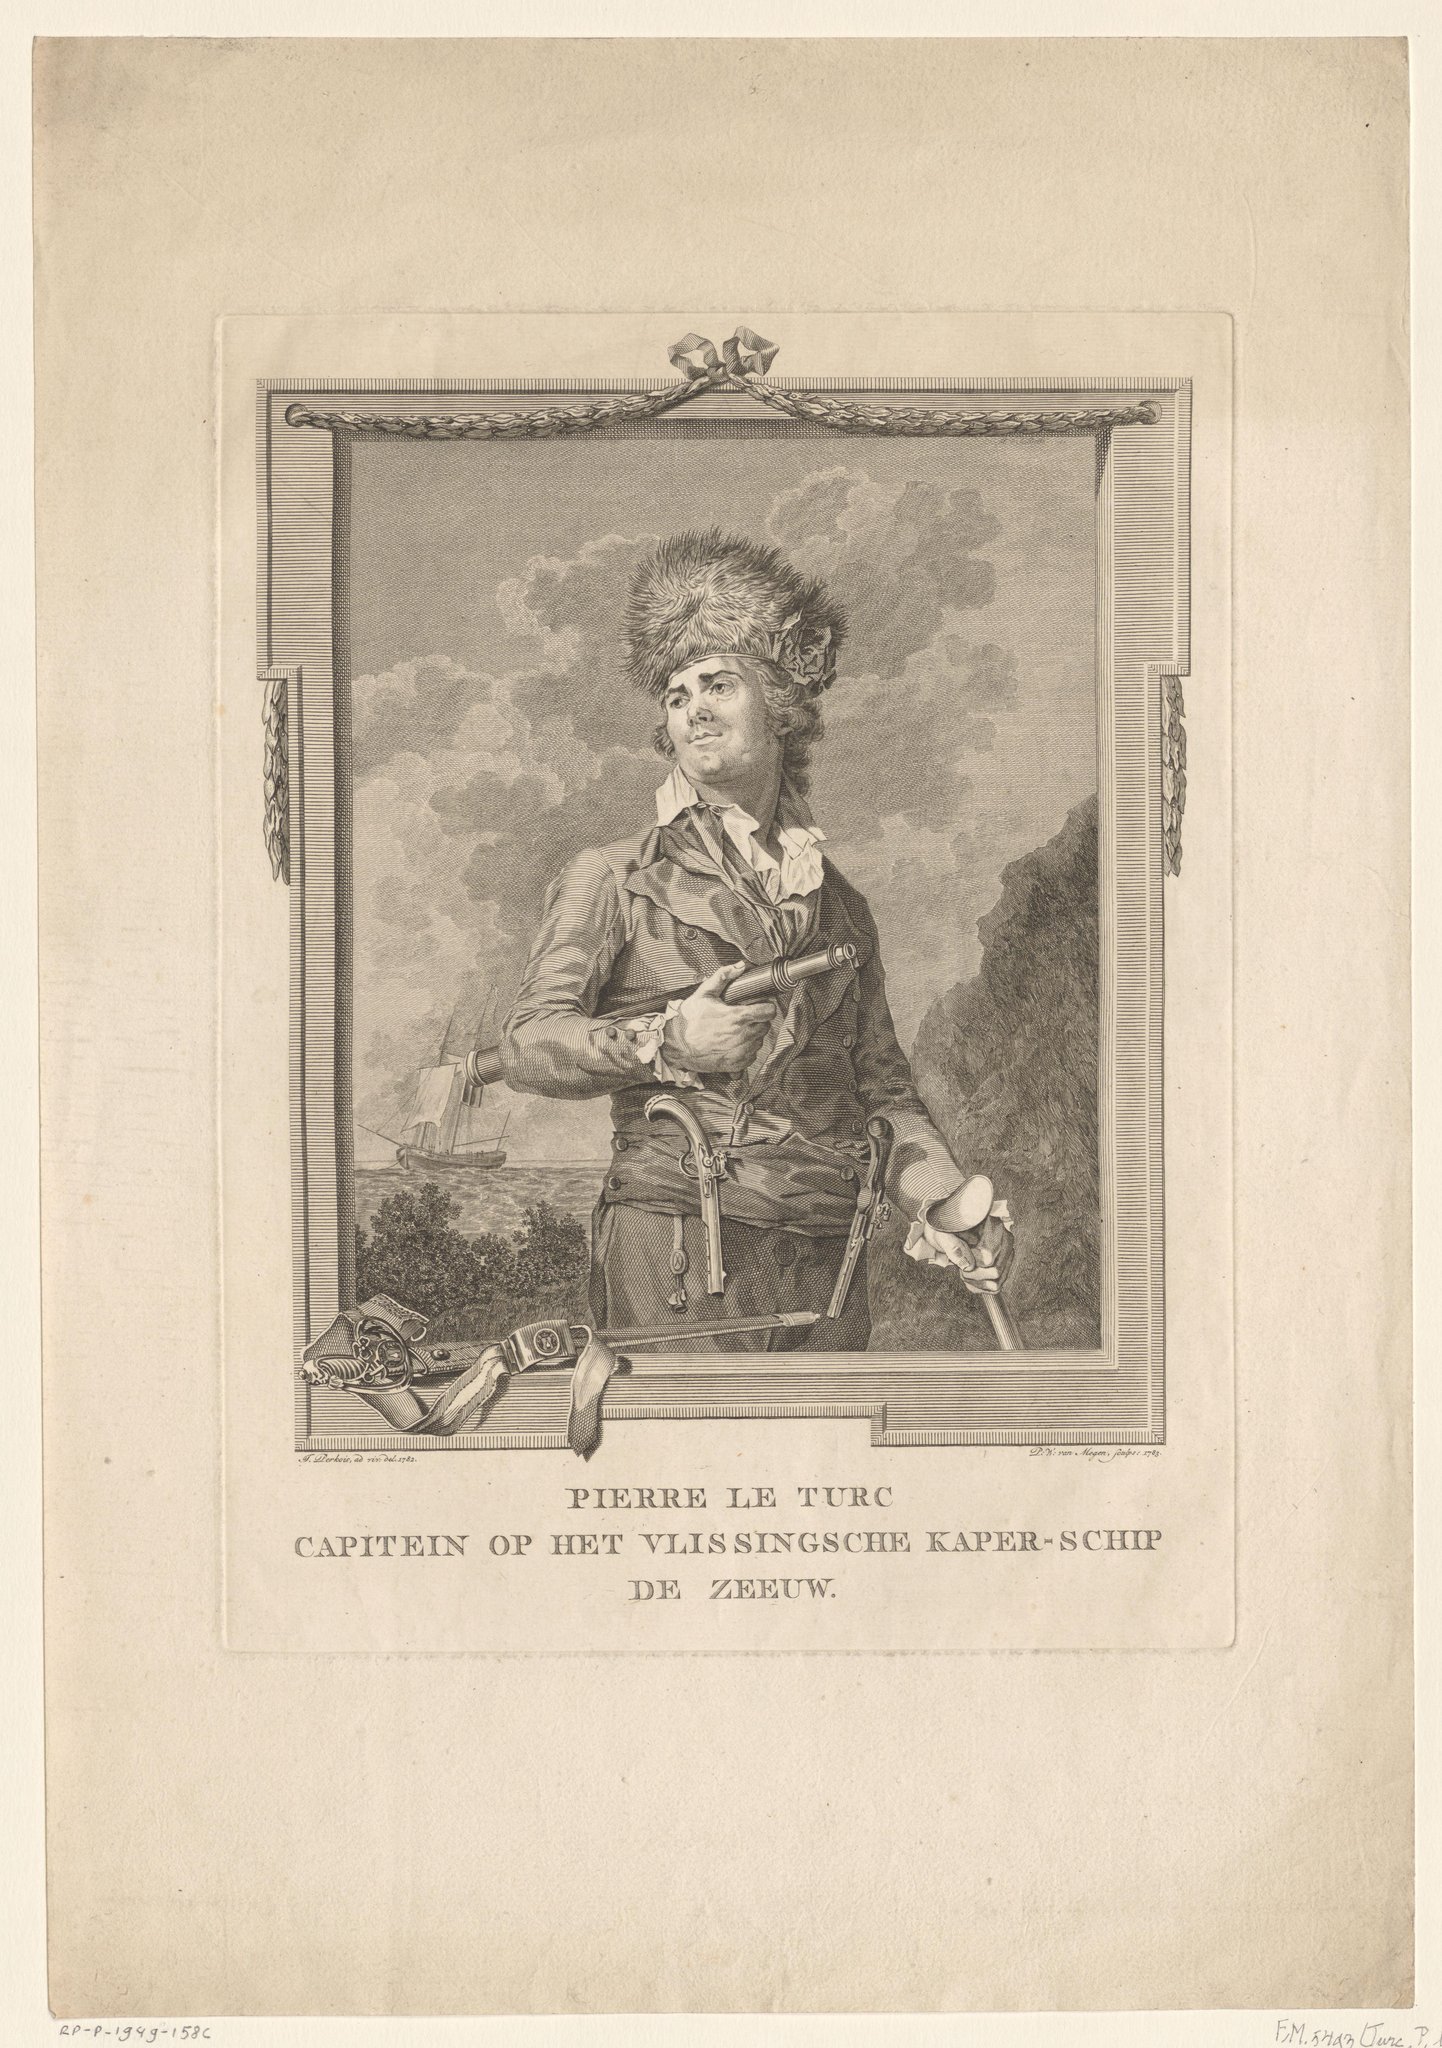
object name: print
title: Portret van Pierre le Turcq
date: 1783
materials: paper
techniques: engraving, etching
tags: capuche, pirate, corsair, buccaneer, ship's portrait, historical persons, hacking and thrusting weapons: sword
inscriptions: collector's mark: Lugt 2228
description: Portret van kaper en kapitein Pierre le Turcq met een verrekijker onder zijn arm en pistolen aan zijn jas. Op de achtergrond zijn schip 'De Zeeuw'. Onder op de lijst ligt een sabel.